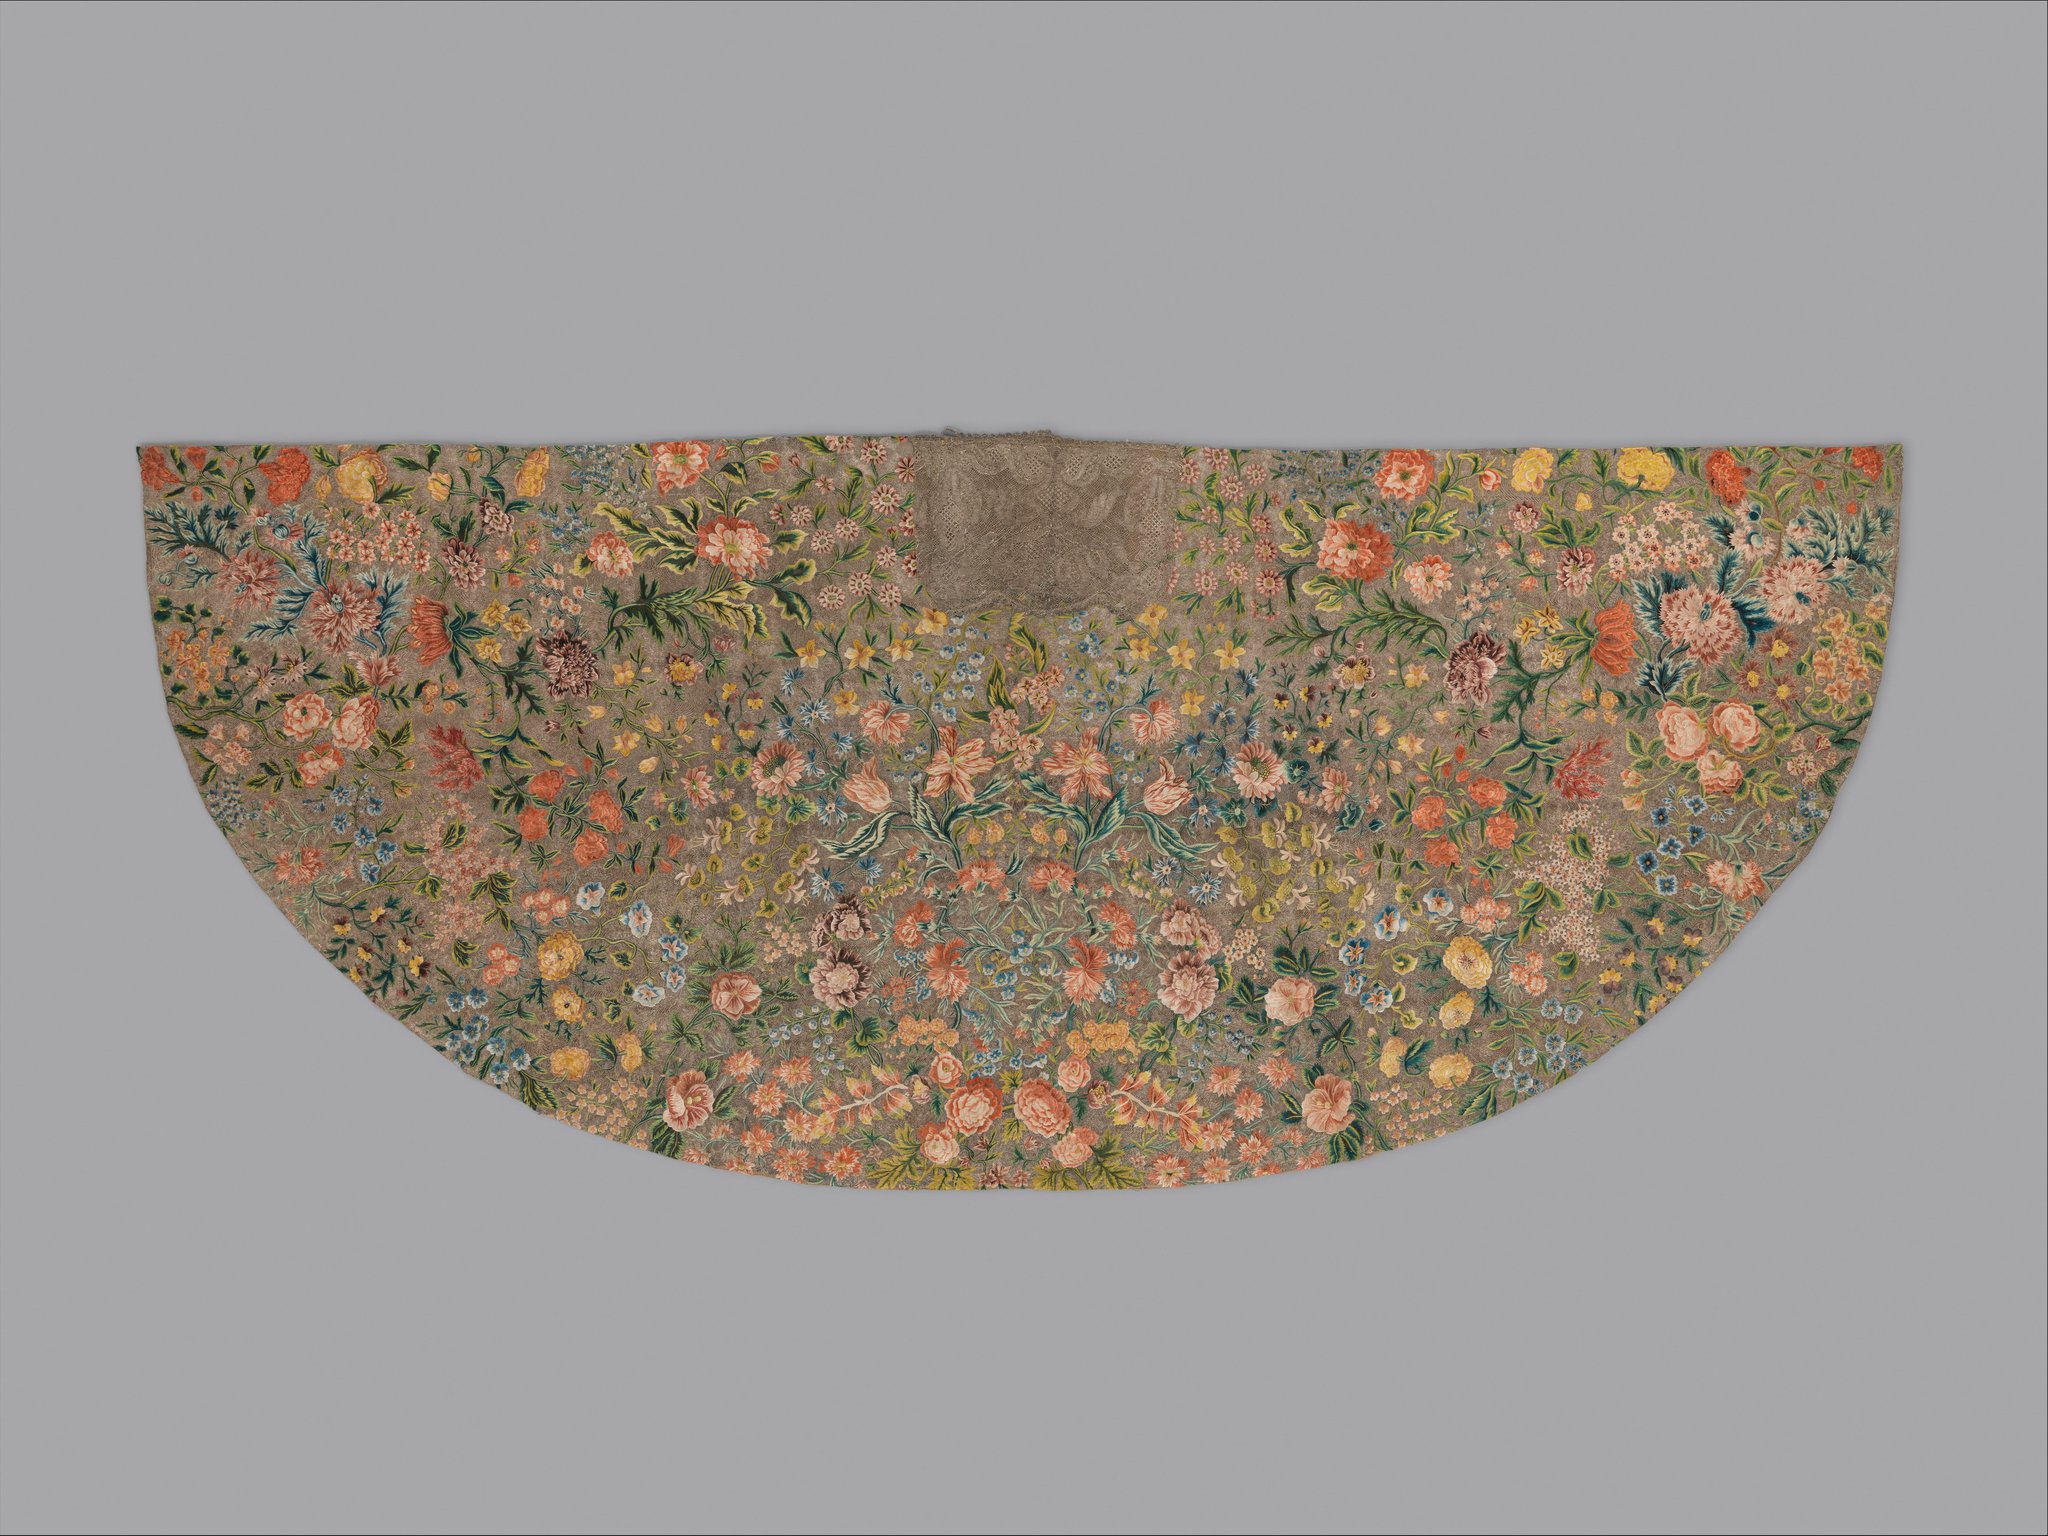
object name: cope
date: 1651-1700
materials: linen, metal thread, silk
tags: flowers